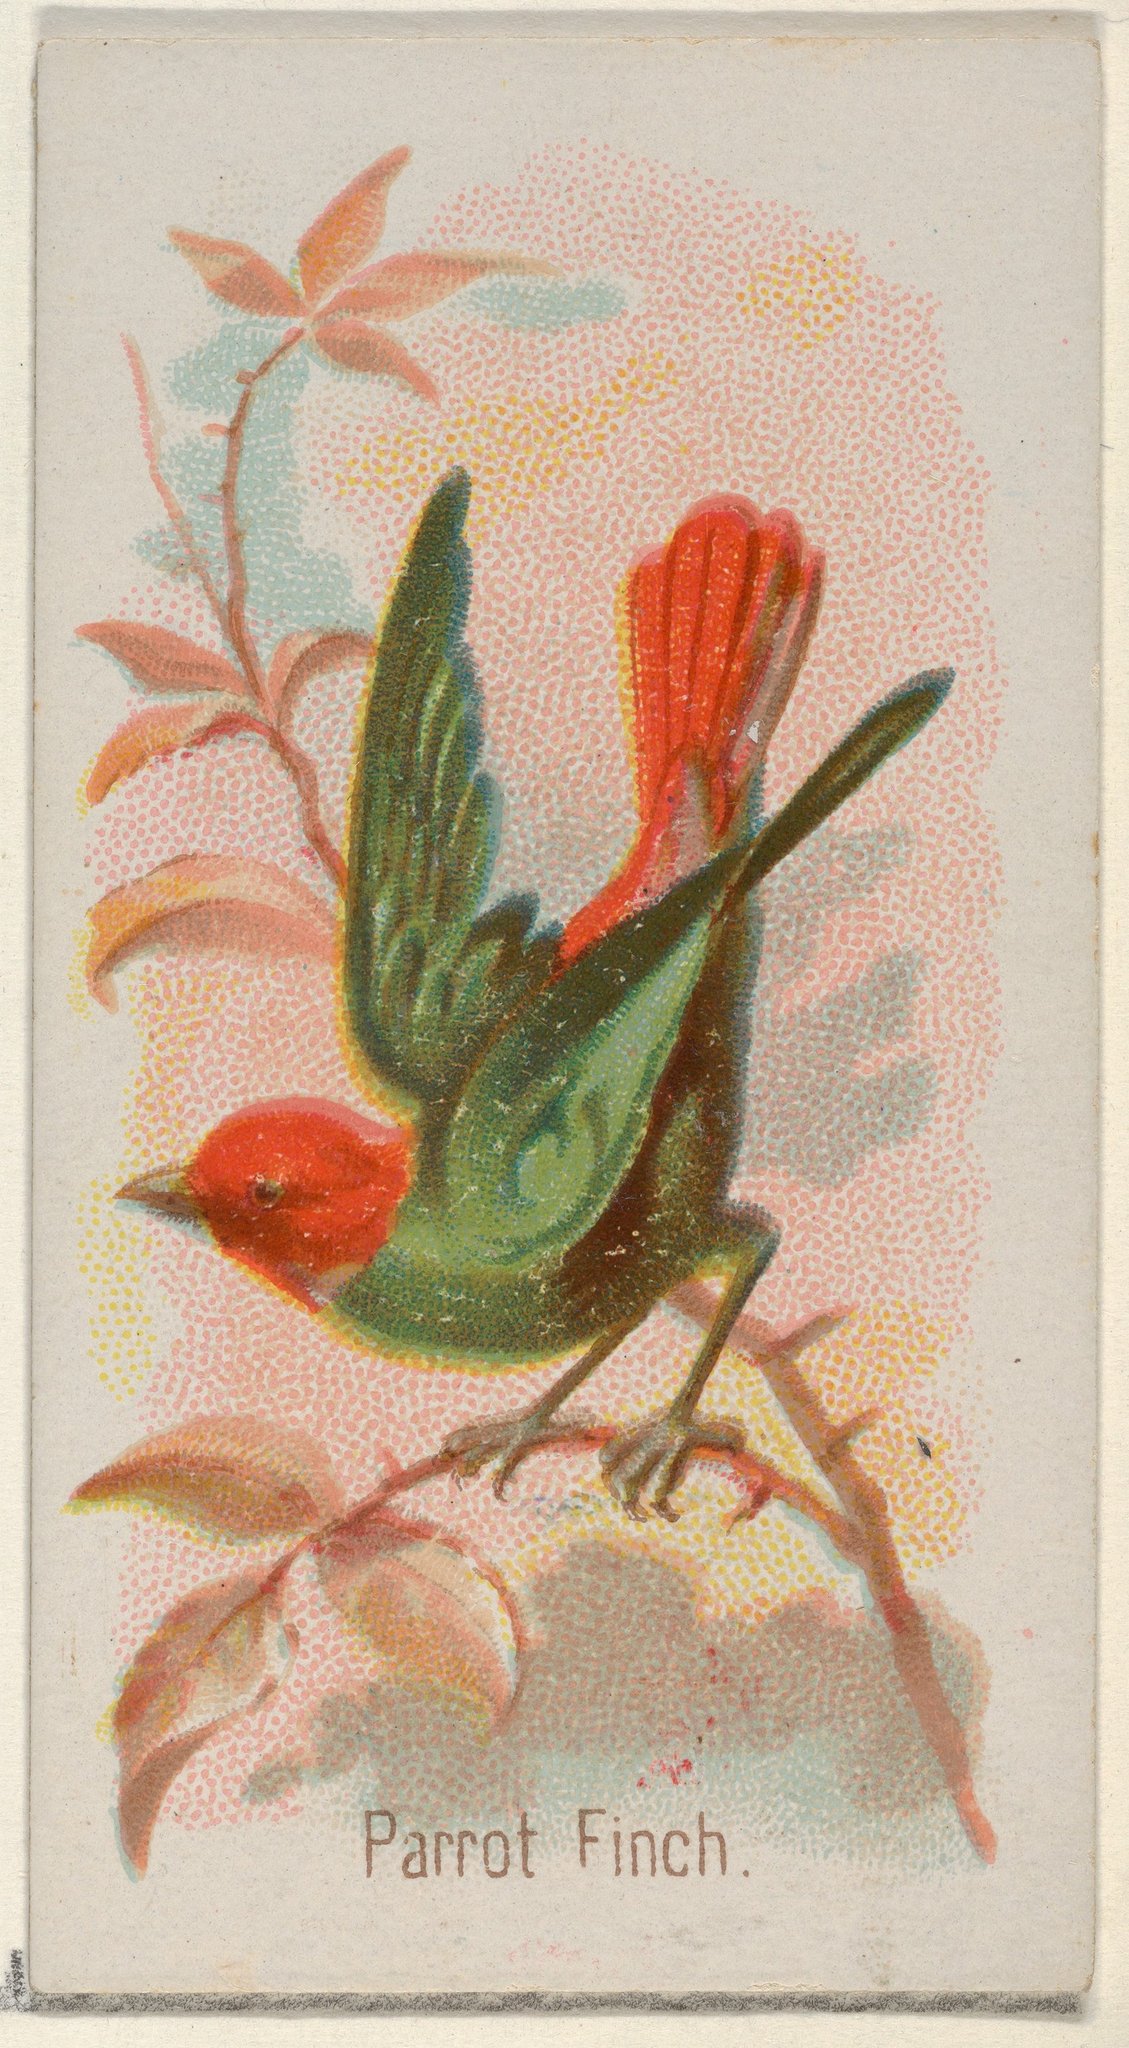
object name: print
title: Parrot Finch, from the Song Birds of the World series (N23) for Allen & Ginter Cigarettes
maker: allen & ginter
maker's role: publisher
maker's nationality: american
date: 1890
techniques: color lithograph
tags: birds